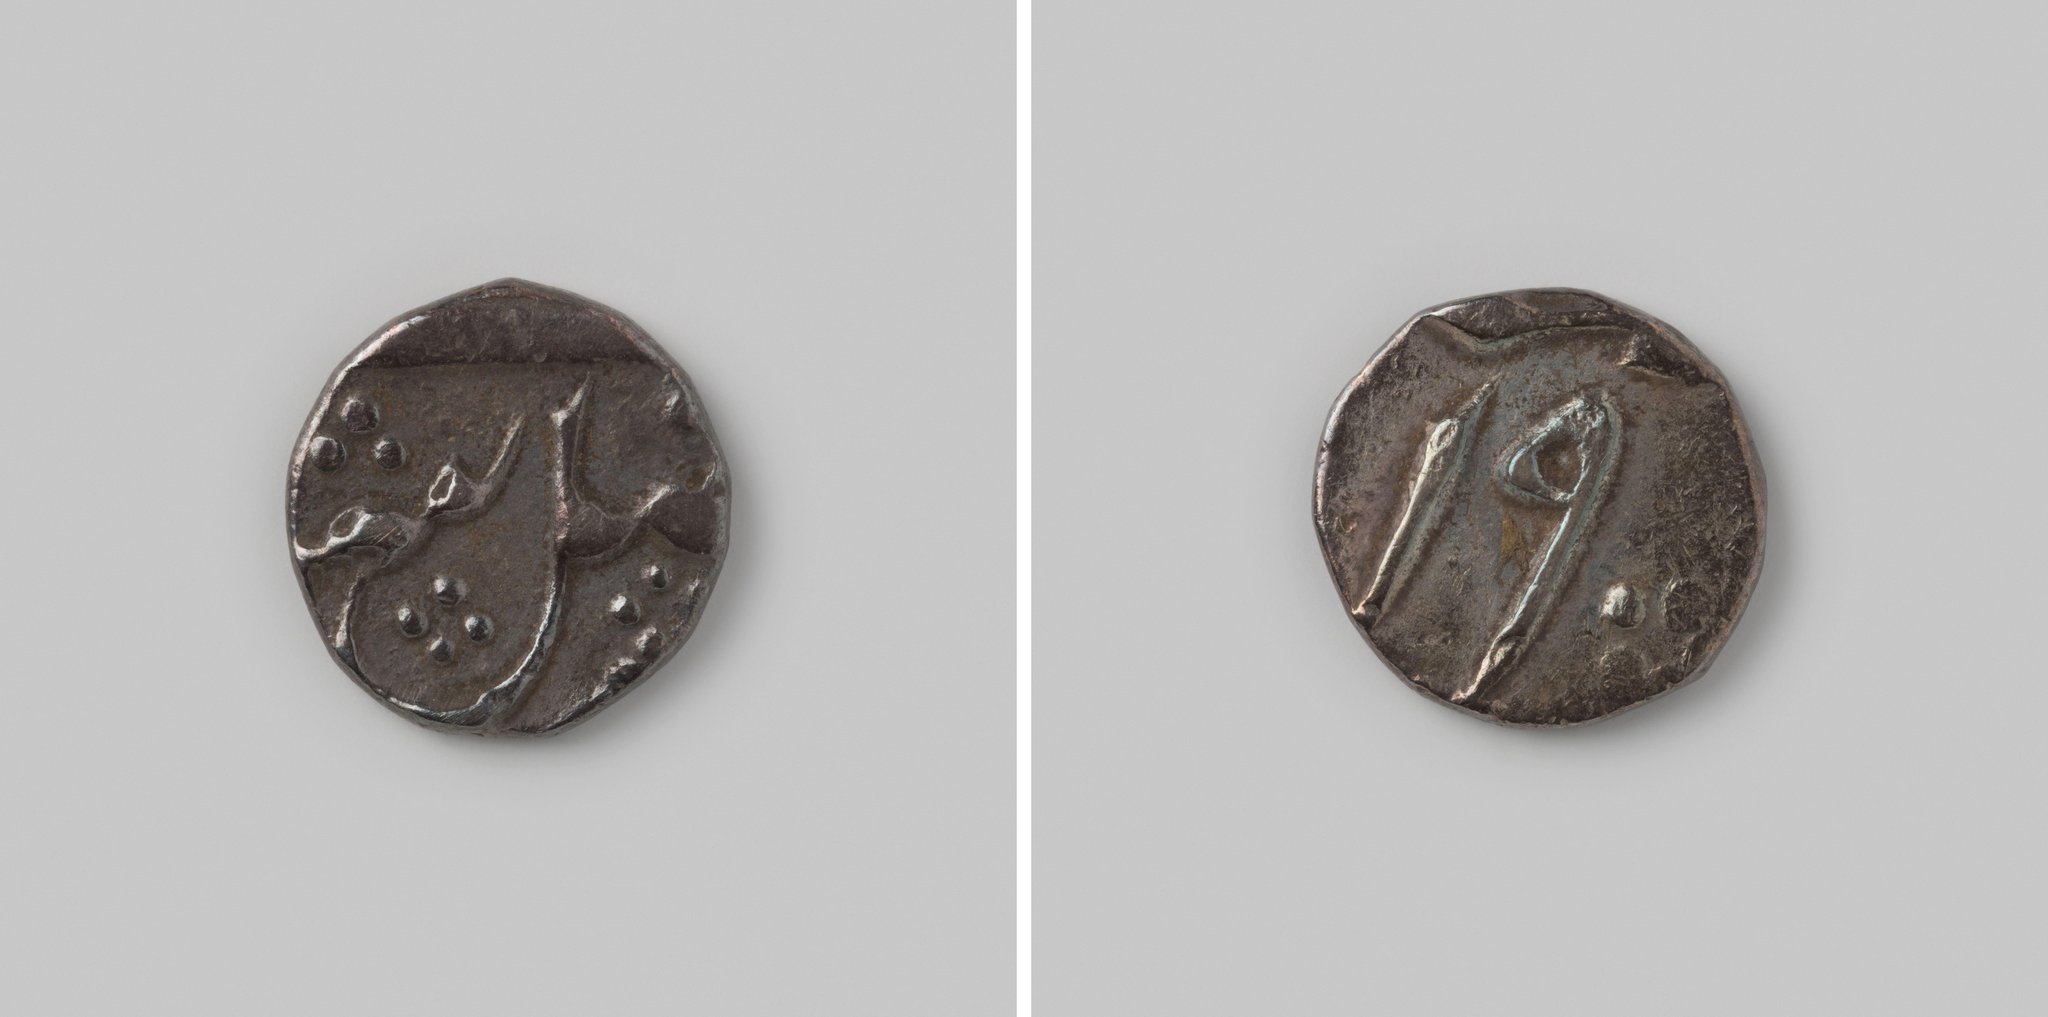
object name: coin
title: 1/8 roepie uit Bengalen in India van de Engelse Oostindische Compagnie (EIC) op naam van Sjah Alam I, 1193 [=1779]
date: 1779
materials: silver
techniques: striking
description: Zilveren munt. Voorzijde: in Arabische lettertekens in twee regels opschrift. Keerzijde: in Arabische lettertekens in twee regels opschrift. Onder eerste regel aanduiding van het "eeuwige" regeringsjaar: 19. Gladde rand.